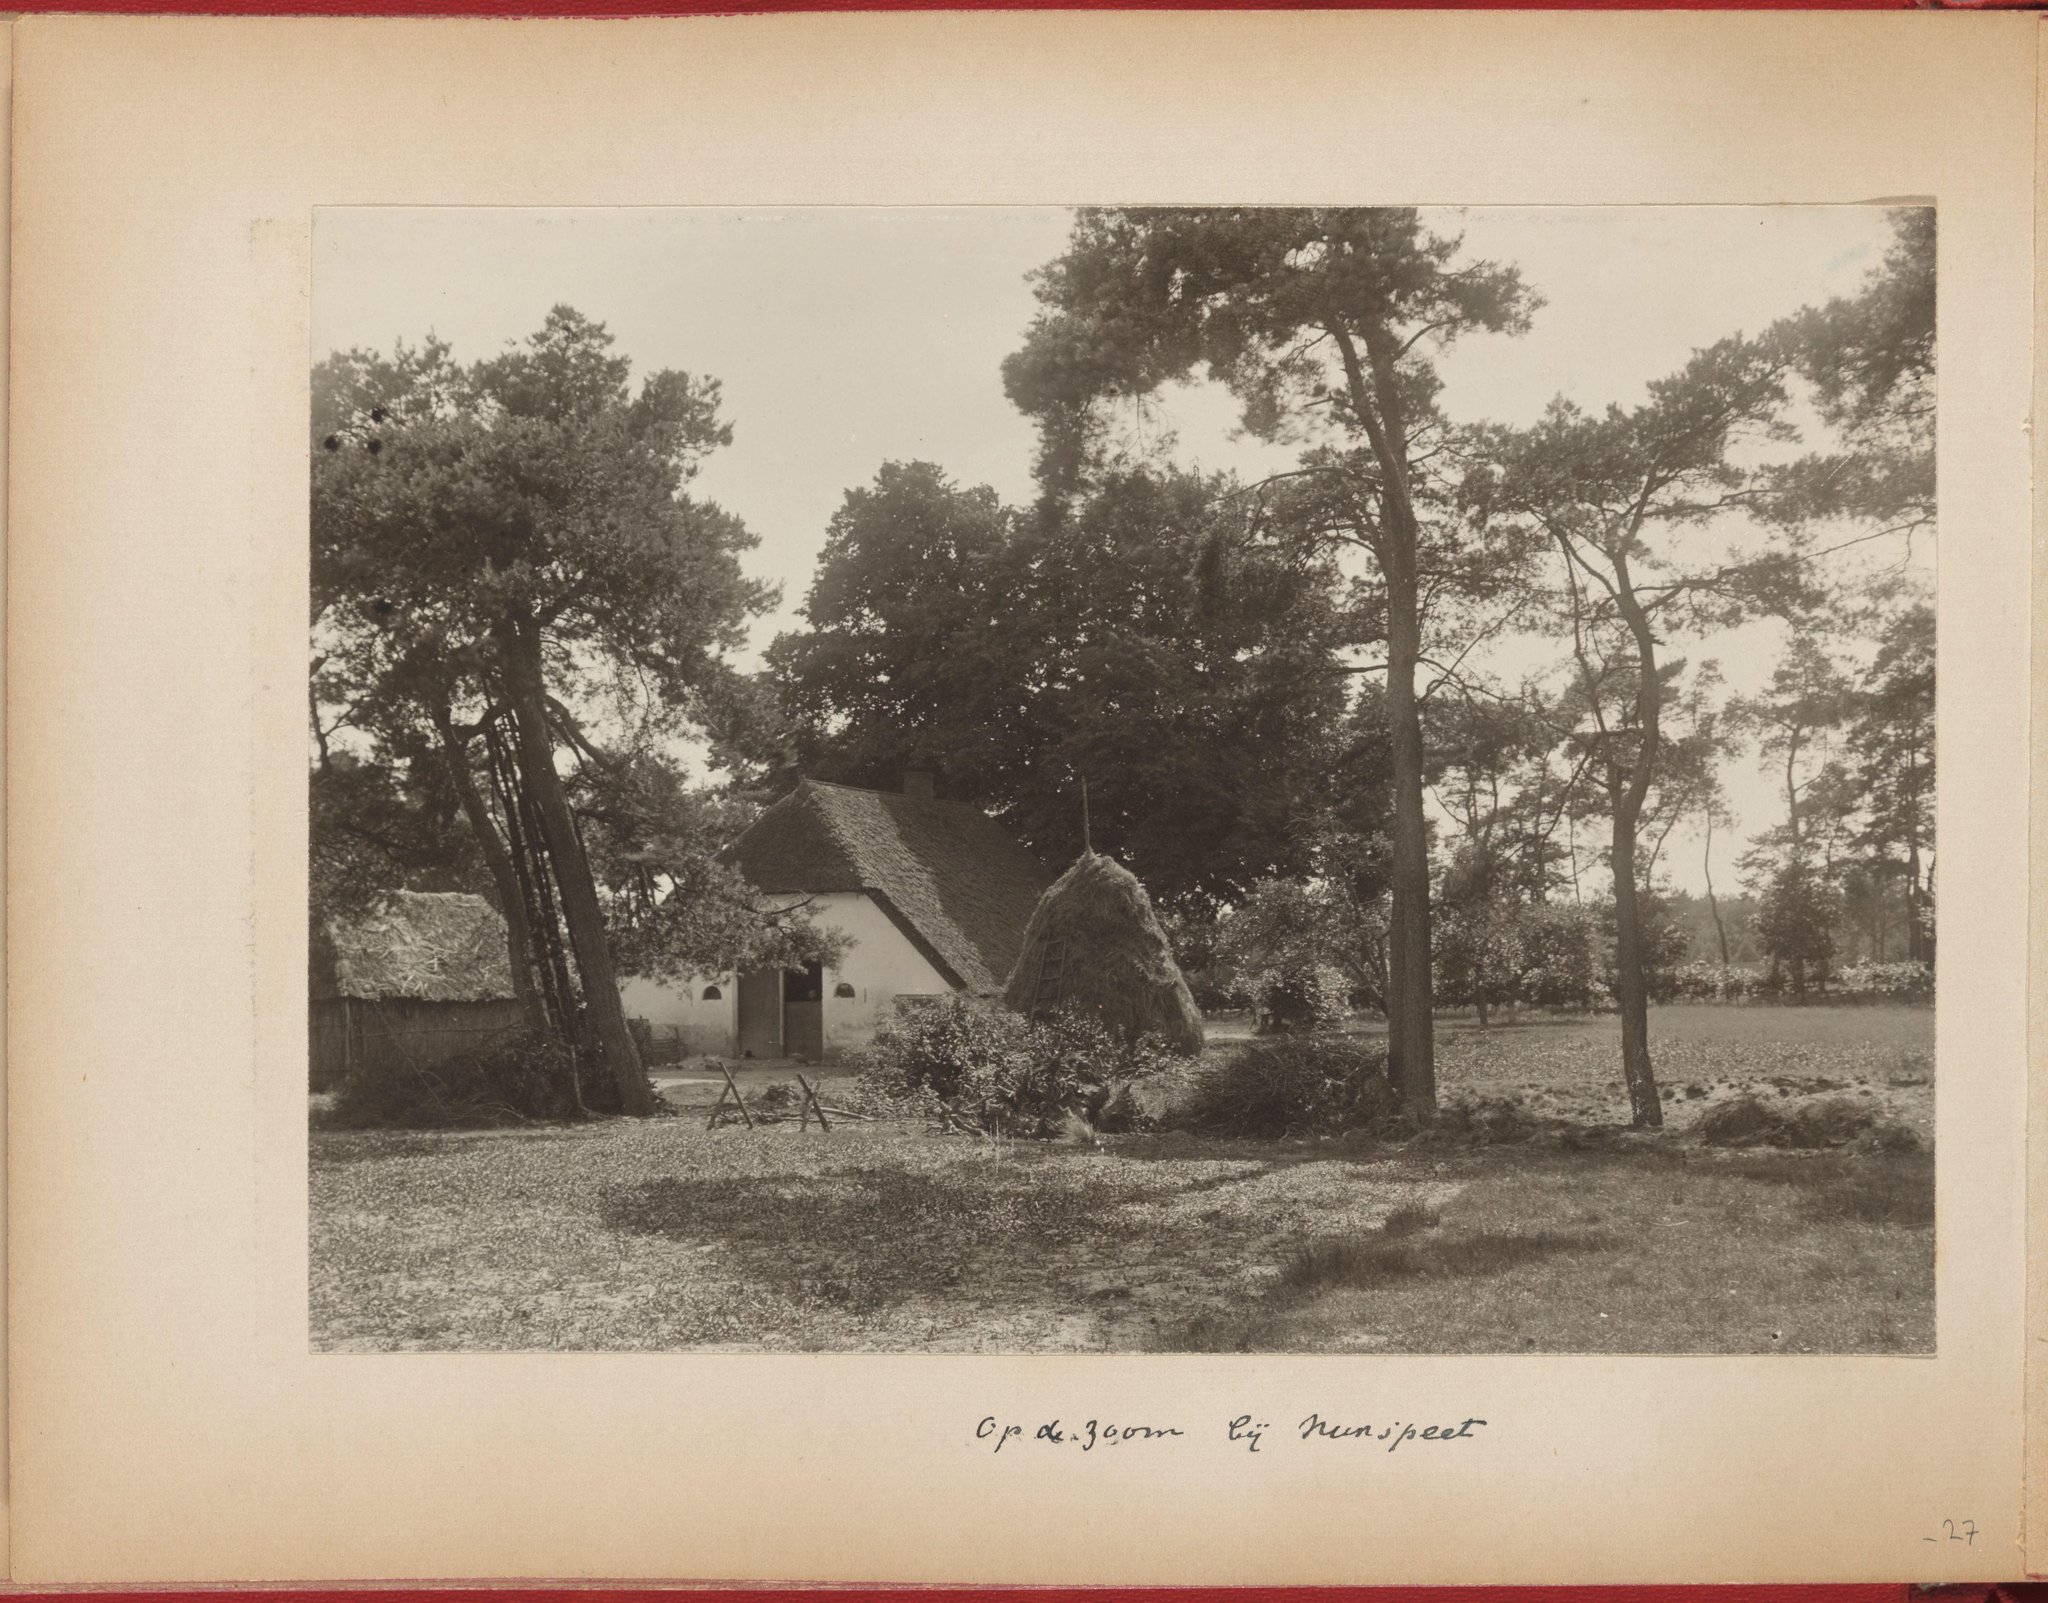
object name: photograph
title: Landschap met een boerderij op de Zoom bij Nunspeet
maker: gerard aalbersberg (us)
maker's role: amateurfotograaf, arts, chirurg, gynaecoloog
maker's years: 1870-1934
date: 1900-1906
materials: paper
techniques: gelatin silver print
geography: nunspeet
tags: nunspeet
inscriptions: title: ‘Op de Zoom bij Nunspeet’